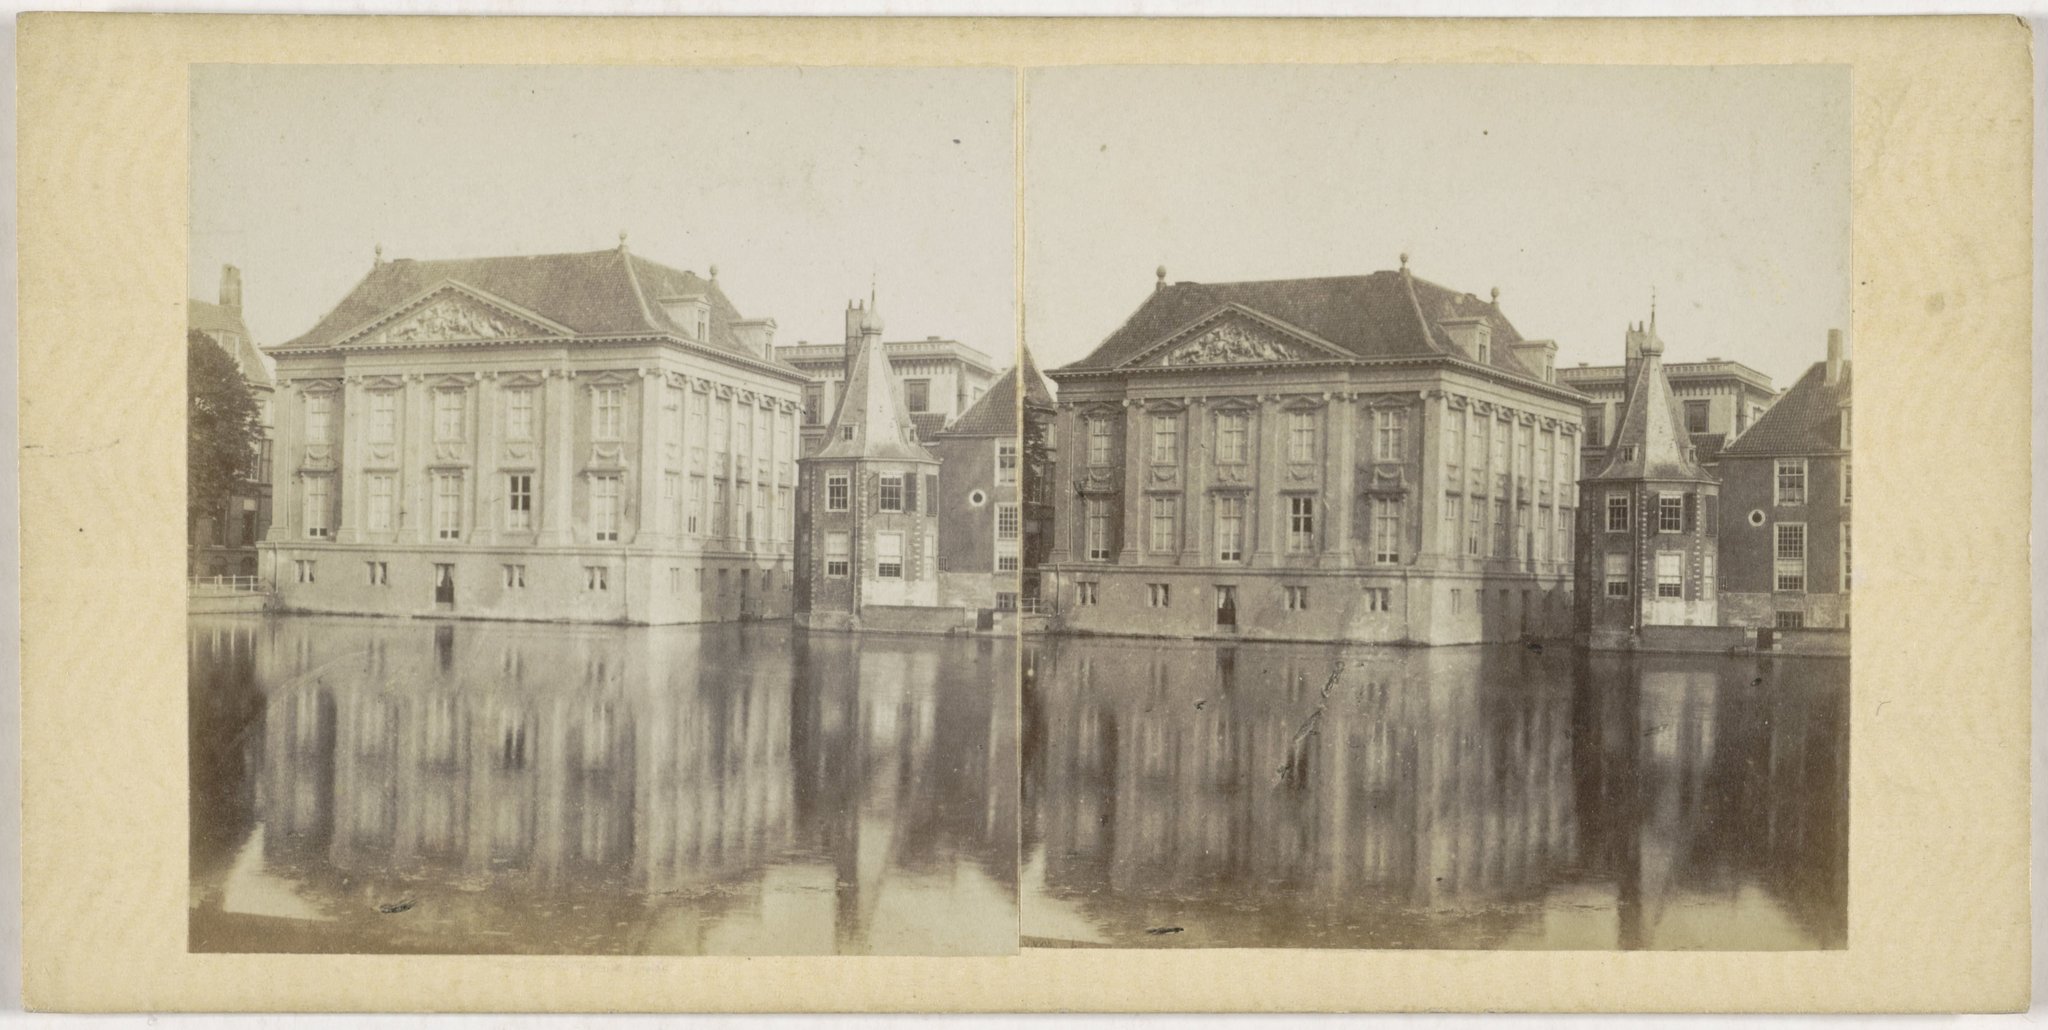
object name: stereograph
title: Mauritshuis Den Haag, gezien vanaf de Lange Vijverberg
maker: Anonymous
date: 1852-1863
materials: cardboard, paper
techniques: albumen print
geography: the hague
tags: pond, pool, exterior ~ representation of a building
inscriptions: inscription: ‘[...] Hollande’